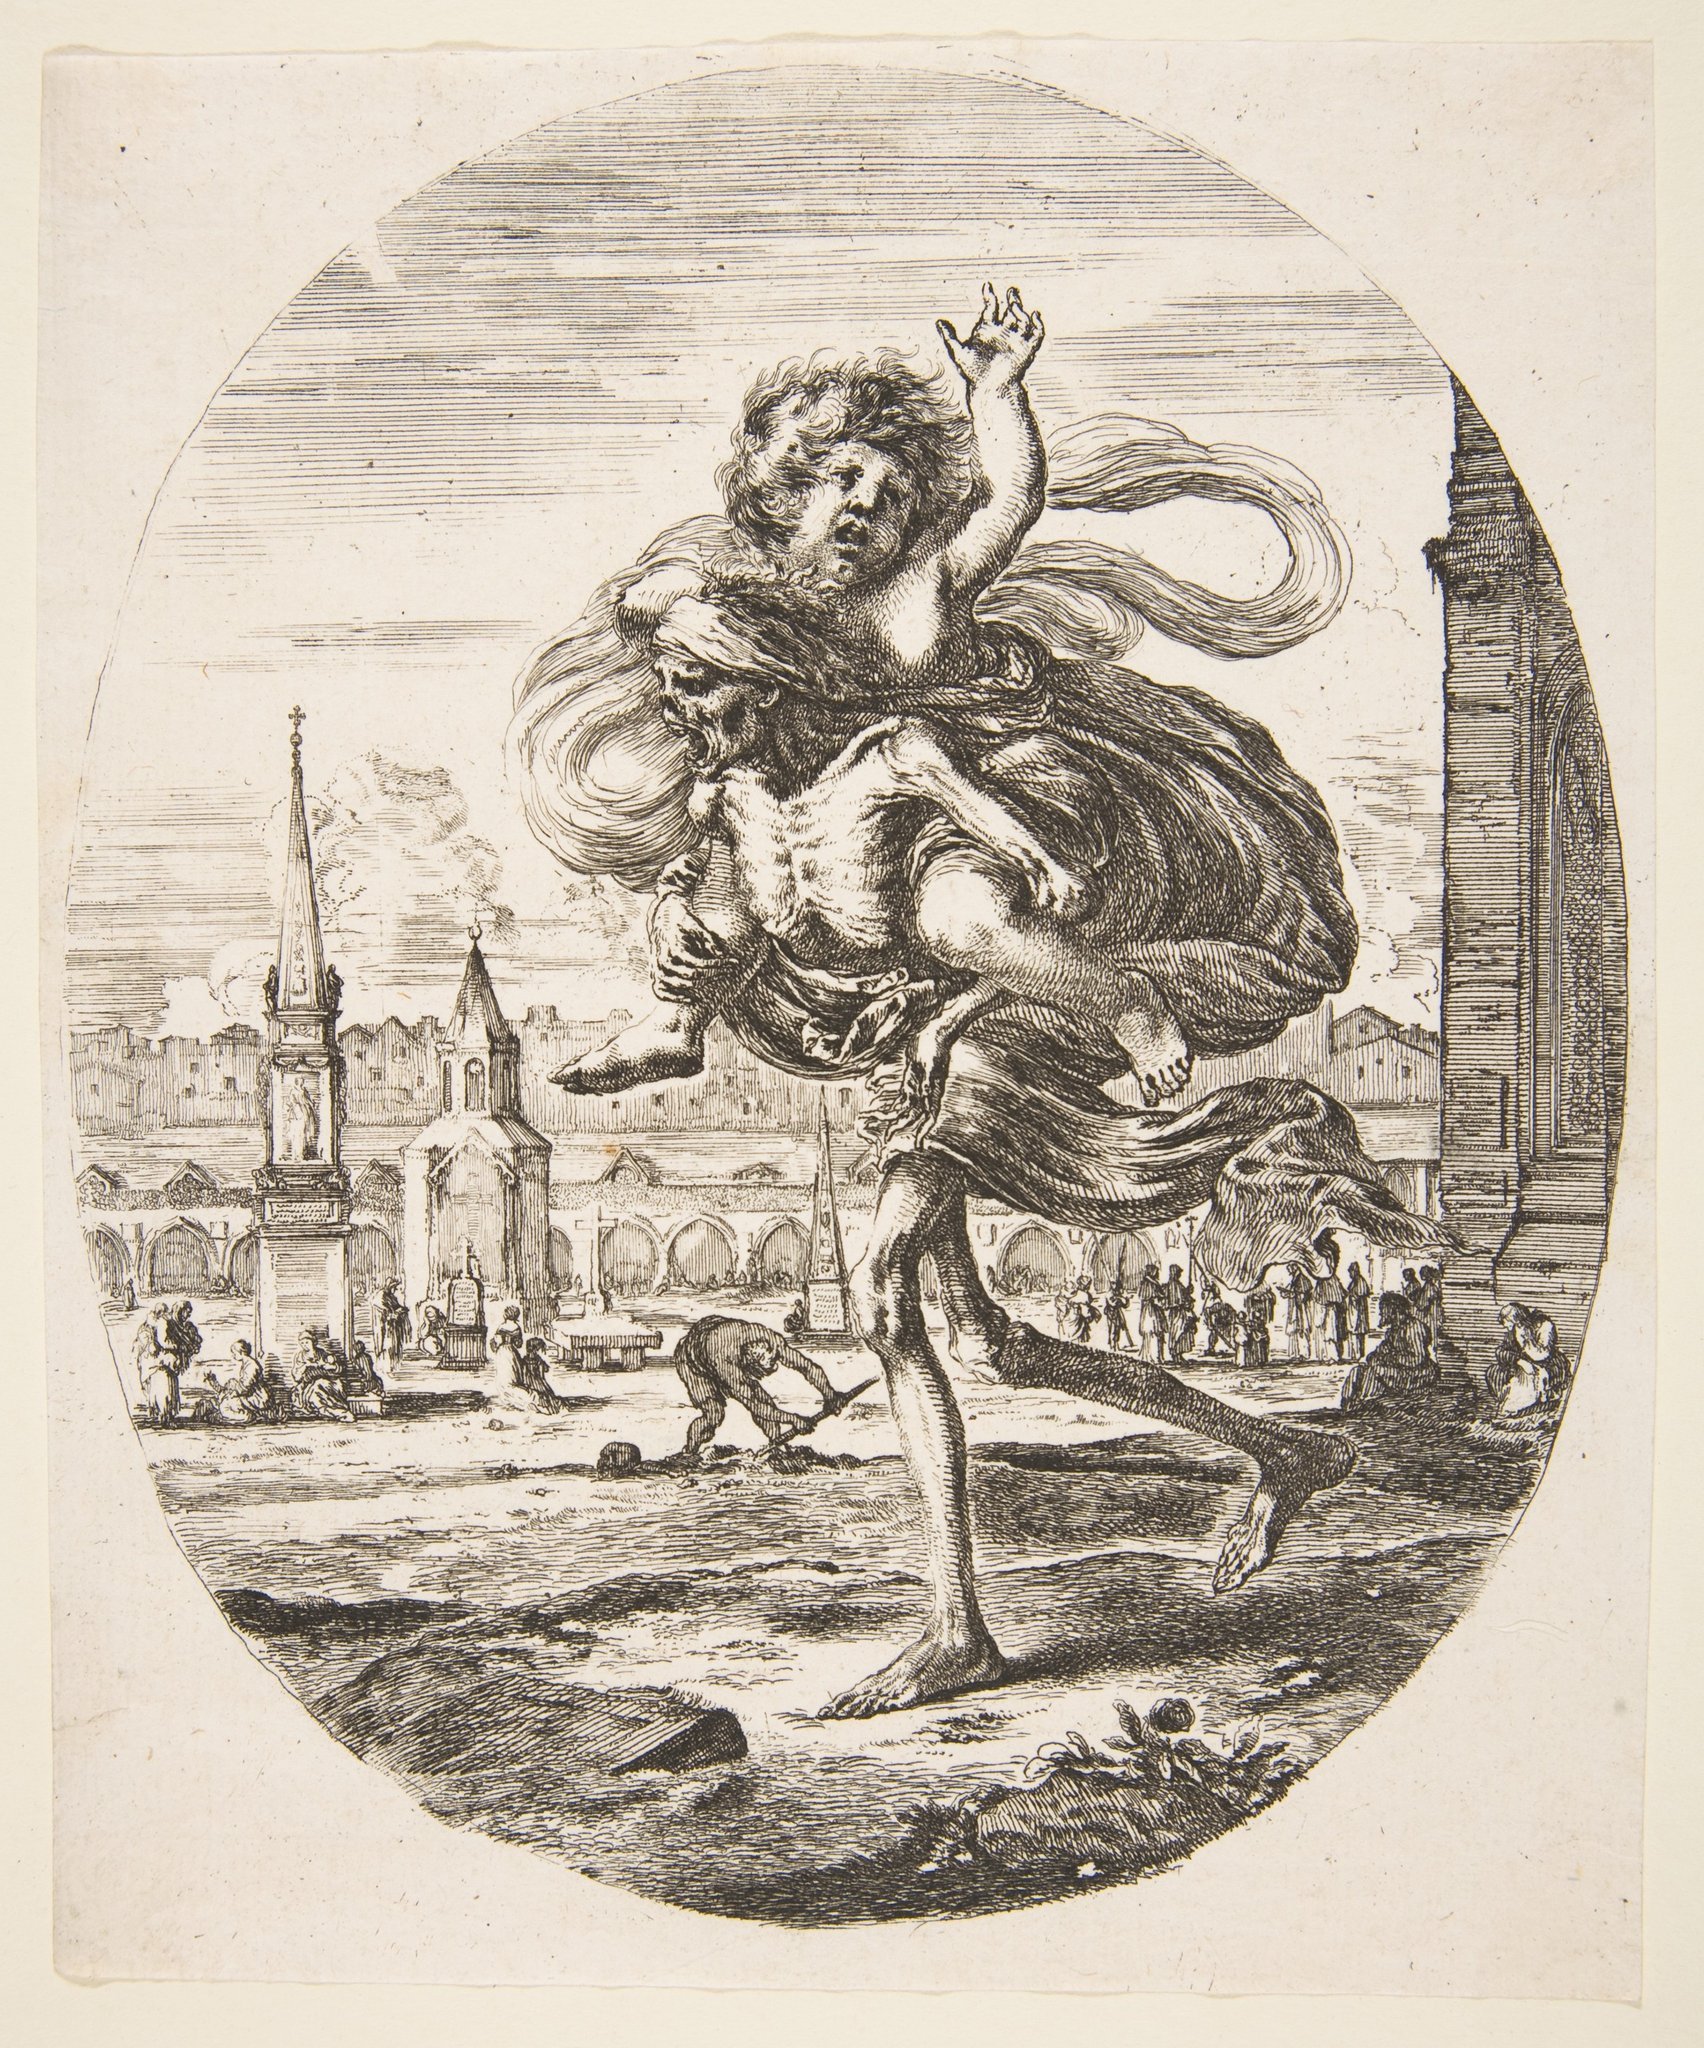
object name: print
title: Death carrying a child, from 'The five deaths' (Les cinq Morts)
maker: stefano della bella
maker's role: printmaker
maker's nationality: italian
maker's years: 1610-1664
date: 1648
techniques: etching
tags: skeletons,children,death